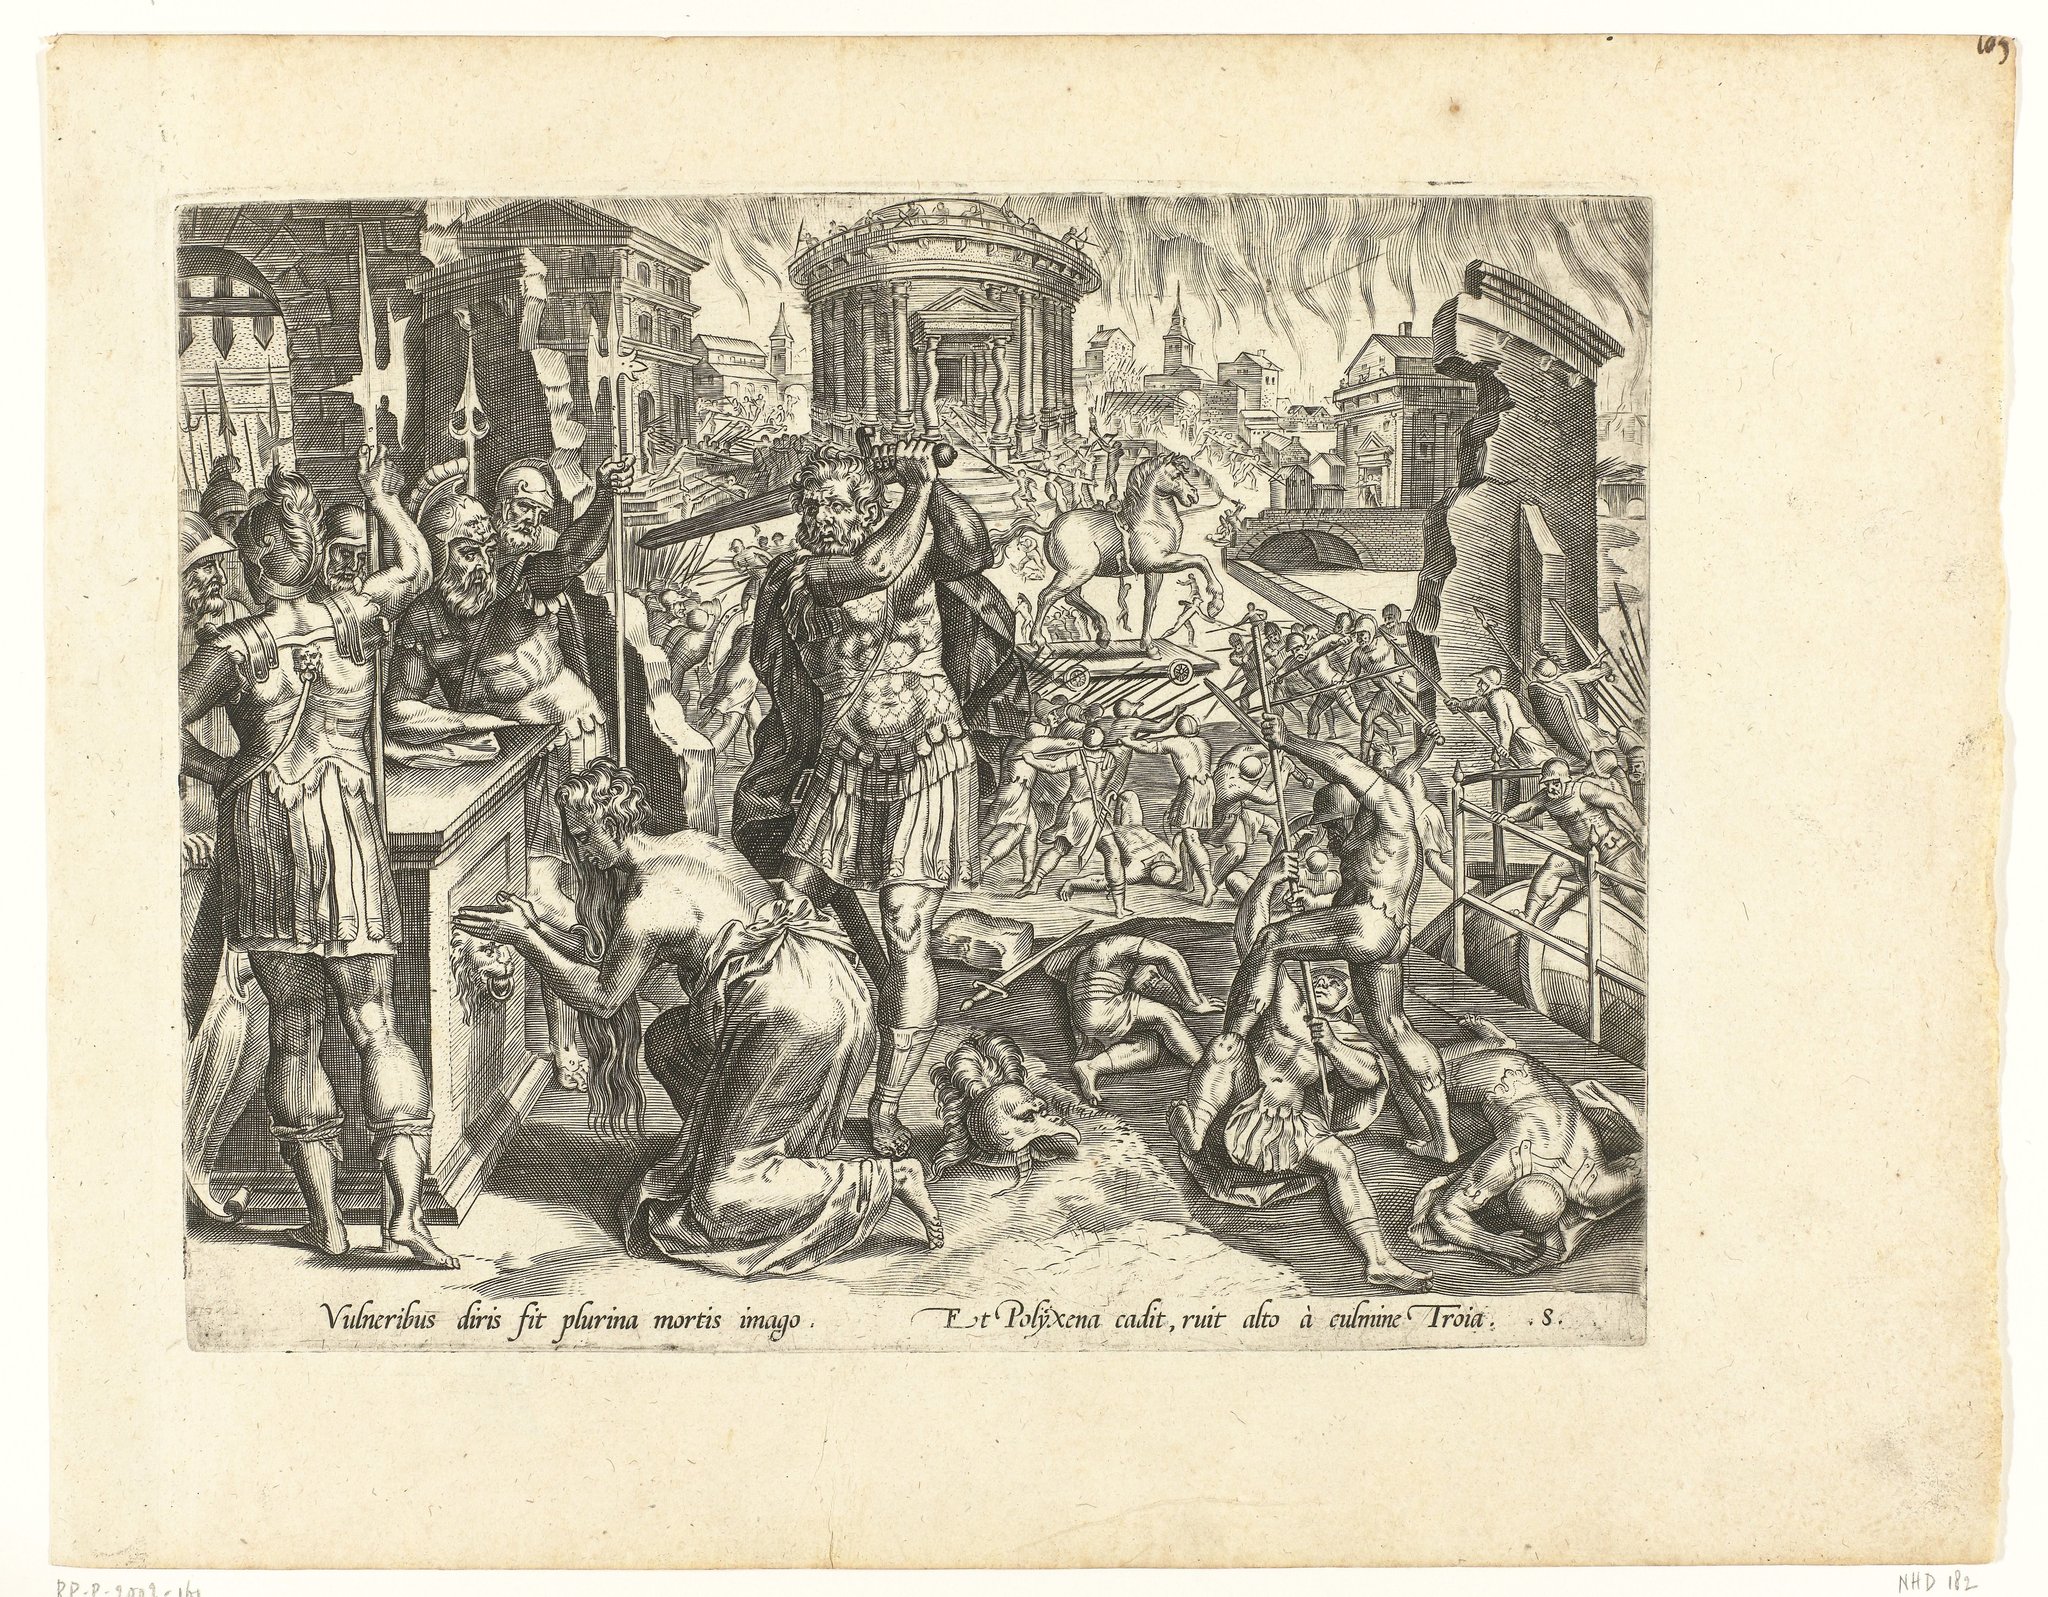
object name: print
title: De Trojaanse oorlog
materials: paper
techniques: engraving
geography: antwerp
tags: polyxena is sacrificed by neoptolemus on achilles' tomb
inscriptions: collector's mark: Lugt 2228, collector's mark: Lugt 2760, number: ‘185’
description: Terwijl er gevochten wordt rond het Trojaanse paard, knielt Polyxena, de jongste dochter van koning Priamus, bij het graf van Achilles. Naast haar staat Neoptolemos met opgeheven zwaard klaar om Polyxena te offeren. Onder de voorstelling staat een regel tekst in het Latijn, rechts genummerd: 8. De prent maakt deel uit van een serie prenten over de Trojaanse oorlog.